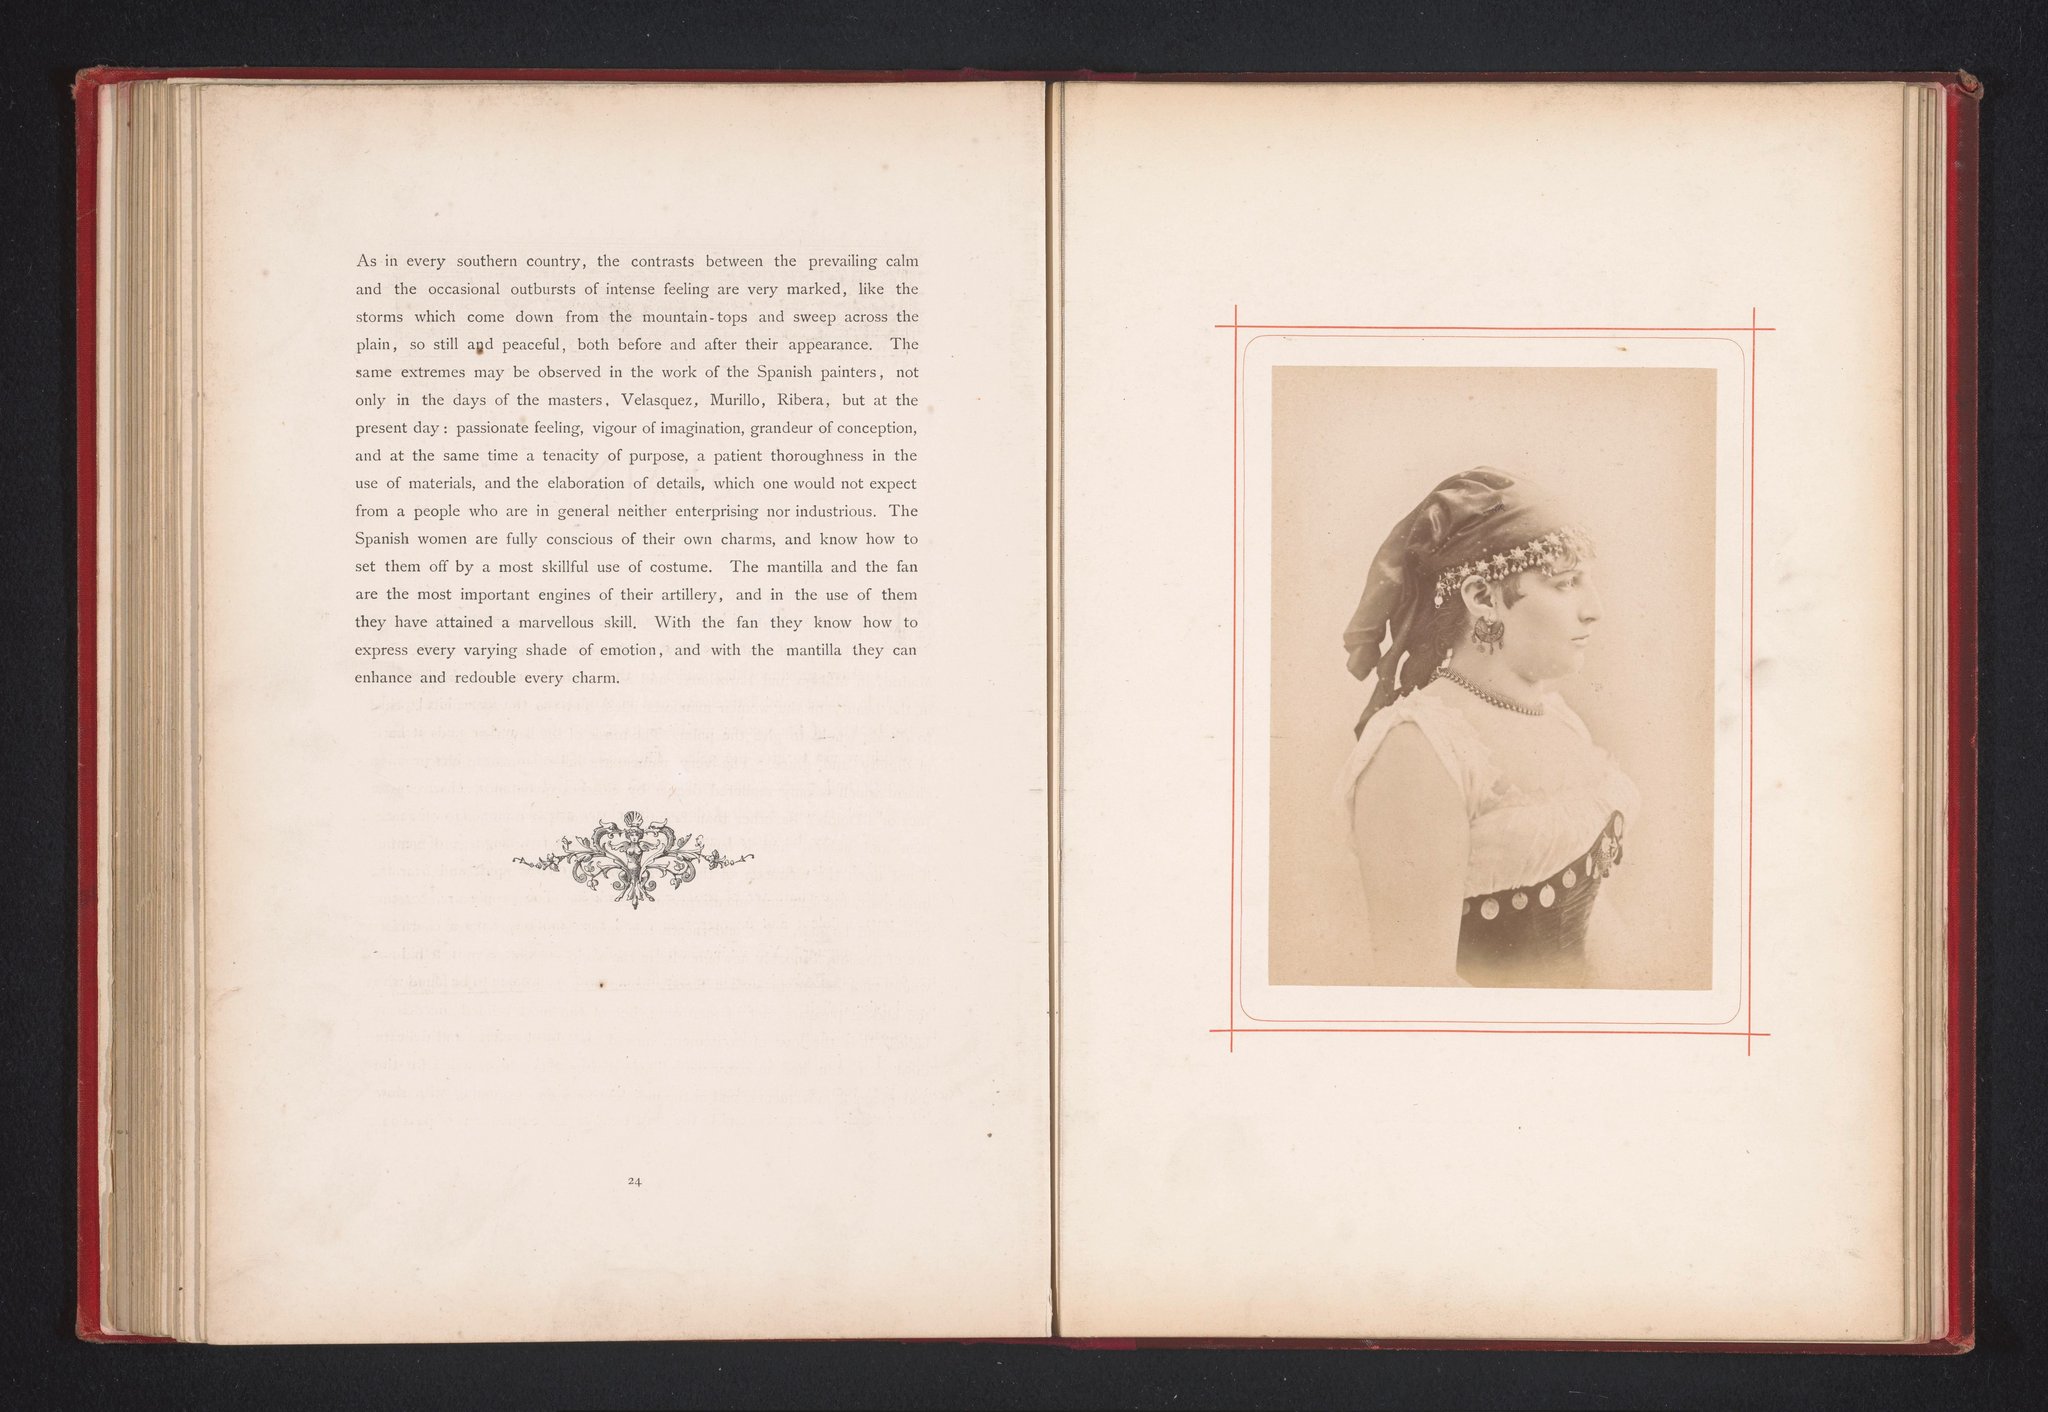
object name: page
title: Portret van een onbekende vrouw in klederdracht uit Egypte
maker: Anonymous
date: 1876-1886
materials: photographic support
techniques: albumen print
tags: folk costume, regional costume, anonymous historical person portrayed - bb - woman